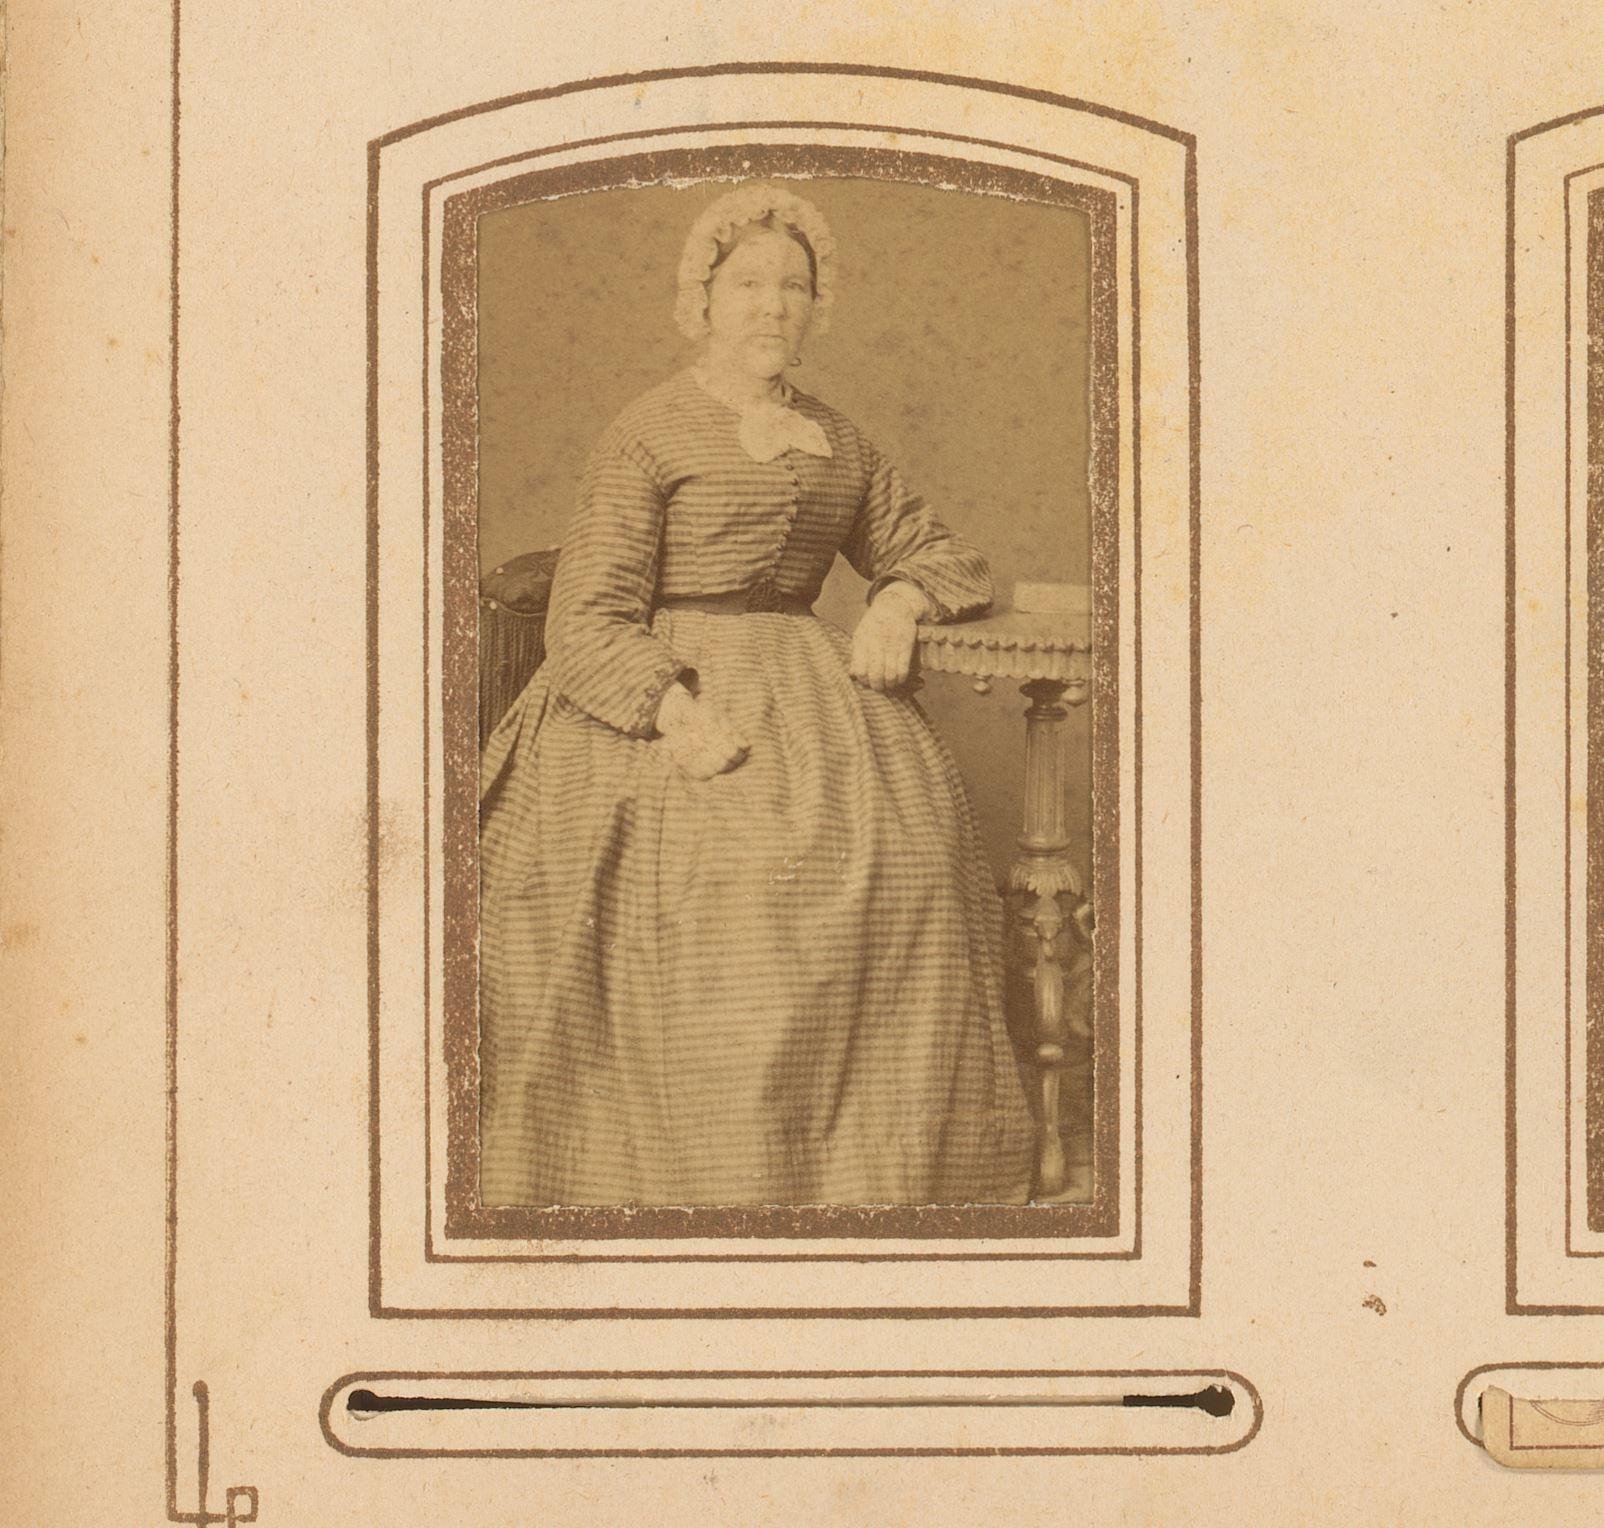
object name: album leaf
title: Portret van een vrouw, zitten bij een tafel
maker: Anonymous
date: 1880-1920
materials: cardboard, photographic support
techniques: albumen print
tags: adult woman, historical persons, table